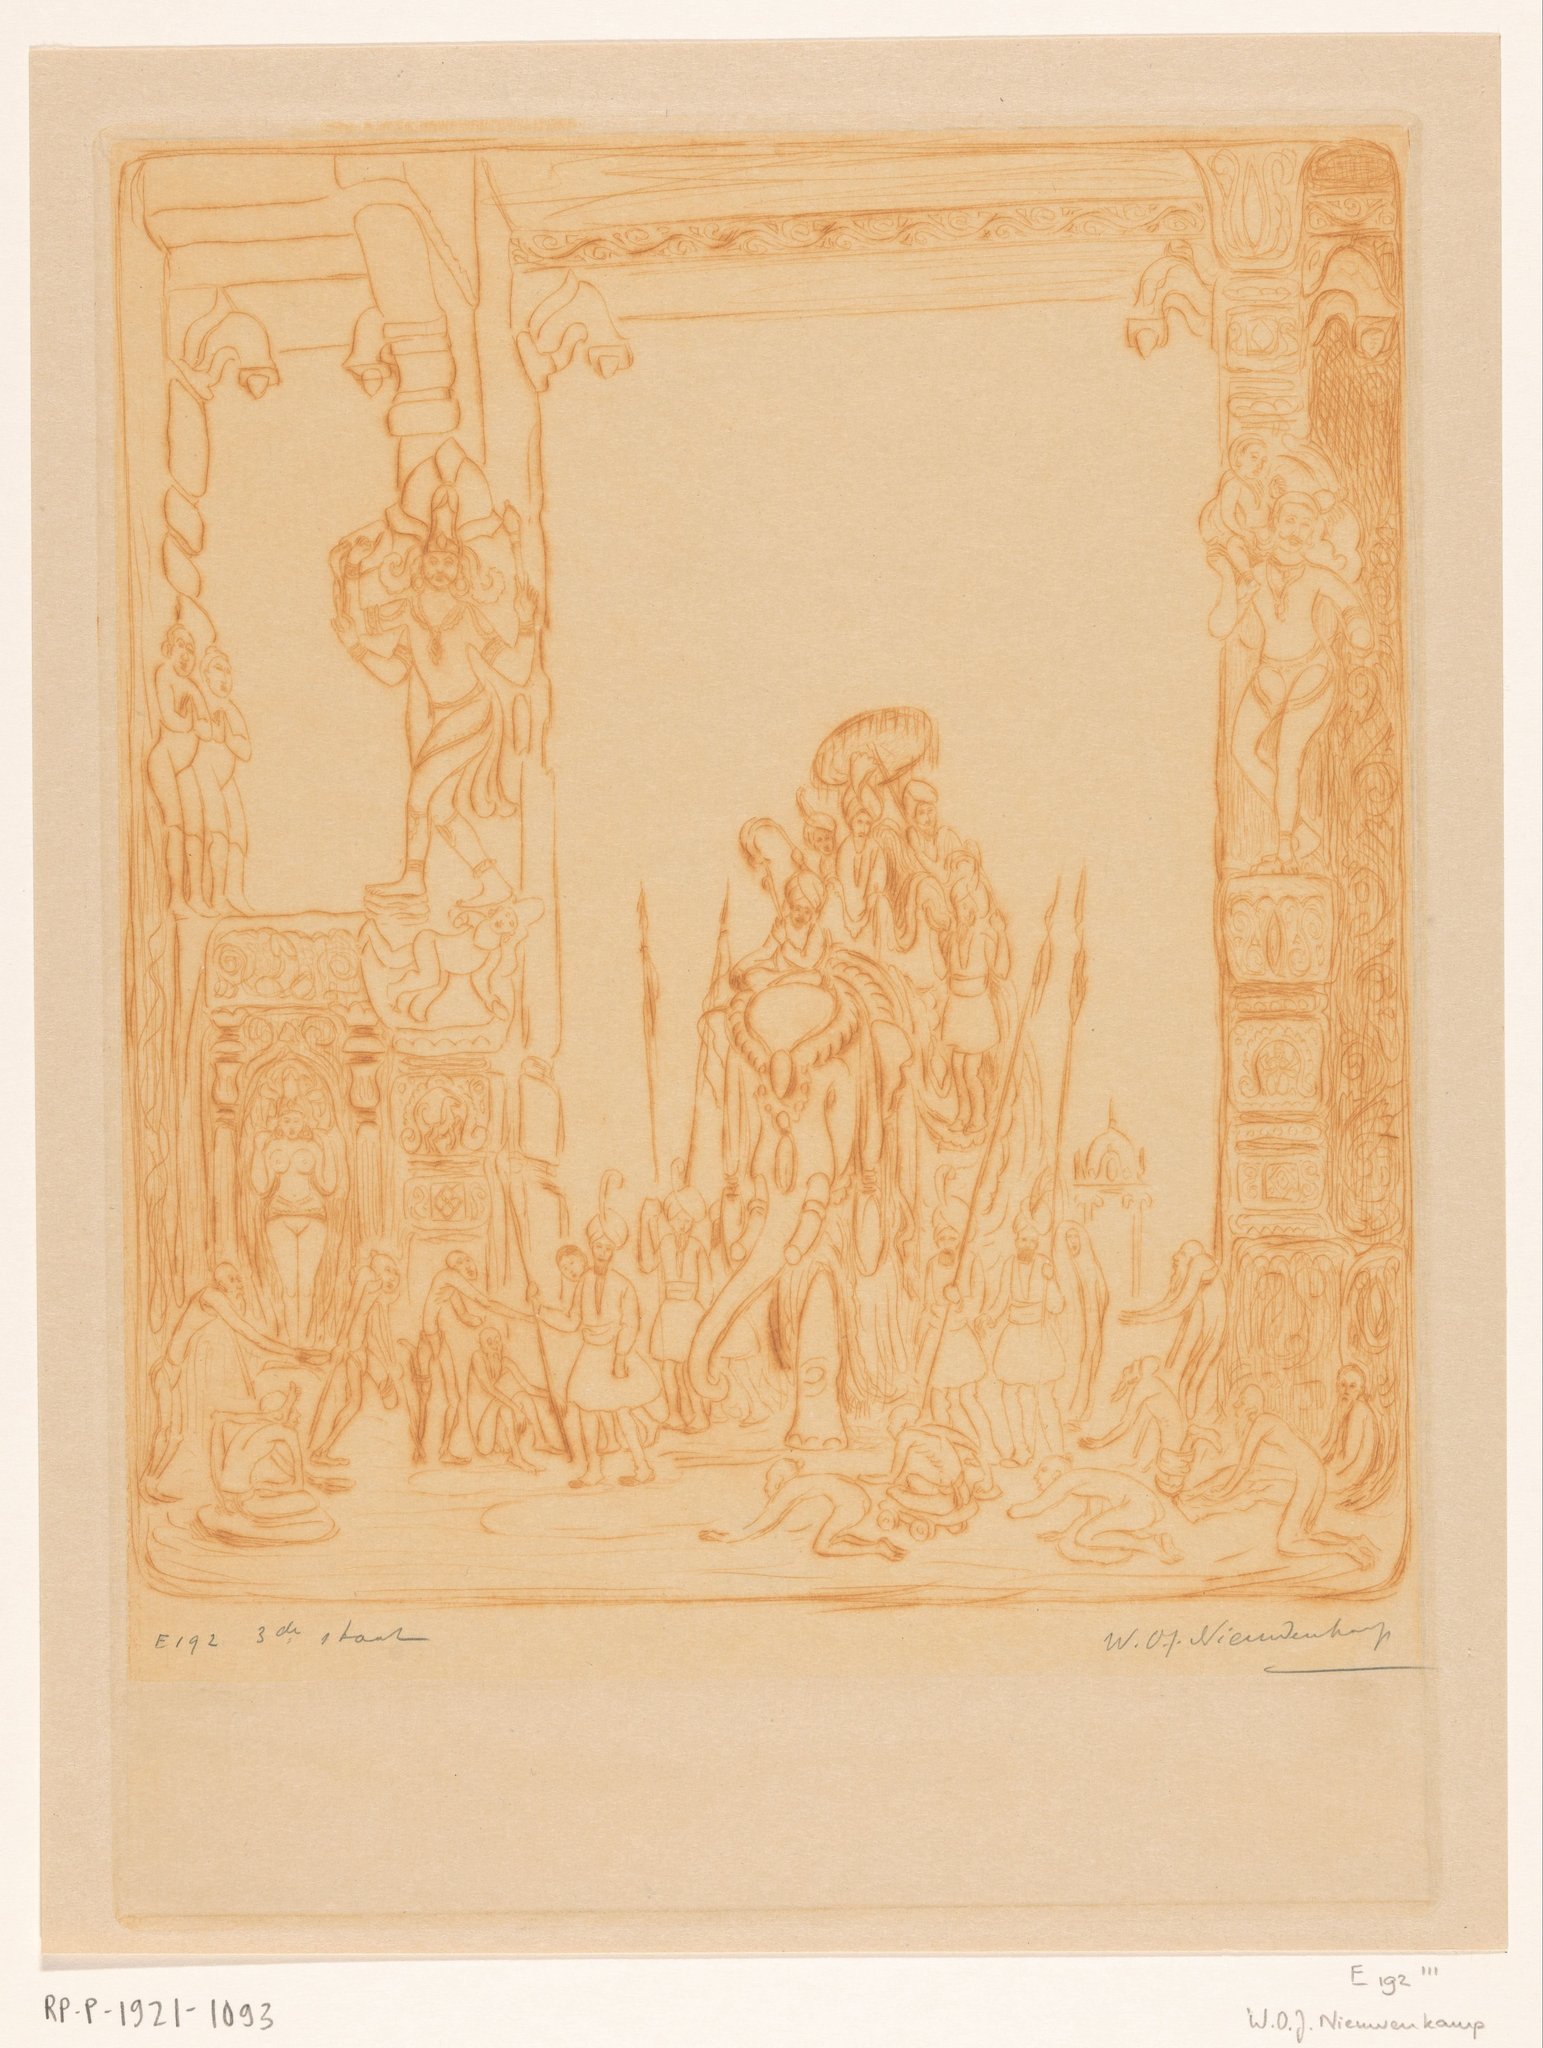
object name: print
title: Figuren op een olifant onder een poort in Madurai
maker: wijnand otto jan nieuwenkamp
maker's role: draughtsman, print maker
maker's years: 1874-1950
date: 1917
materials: paper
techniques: drypoint, intaglio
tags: contrast between rich and poor, riding on animal other than horse, ass, or mule, beggar, city-gate, trunked animals: elephant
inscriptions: collector's mark: Lugt 2233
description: De olifant wordt begeleid door figuren met lansen. De poort is versierd met sculpturen. Op de voorgrond knielende figuren die hun handen ophouden in een bedelend gebaar.